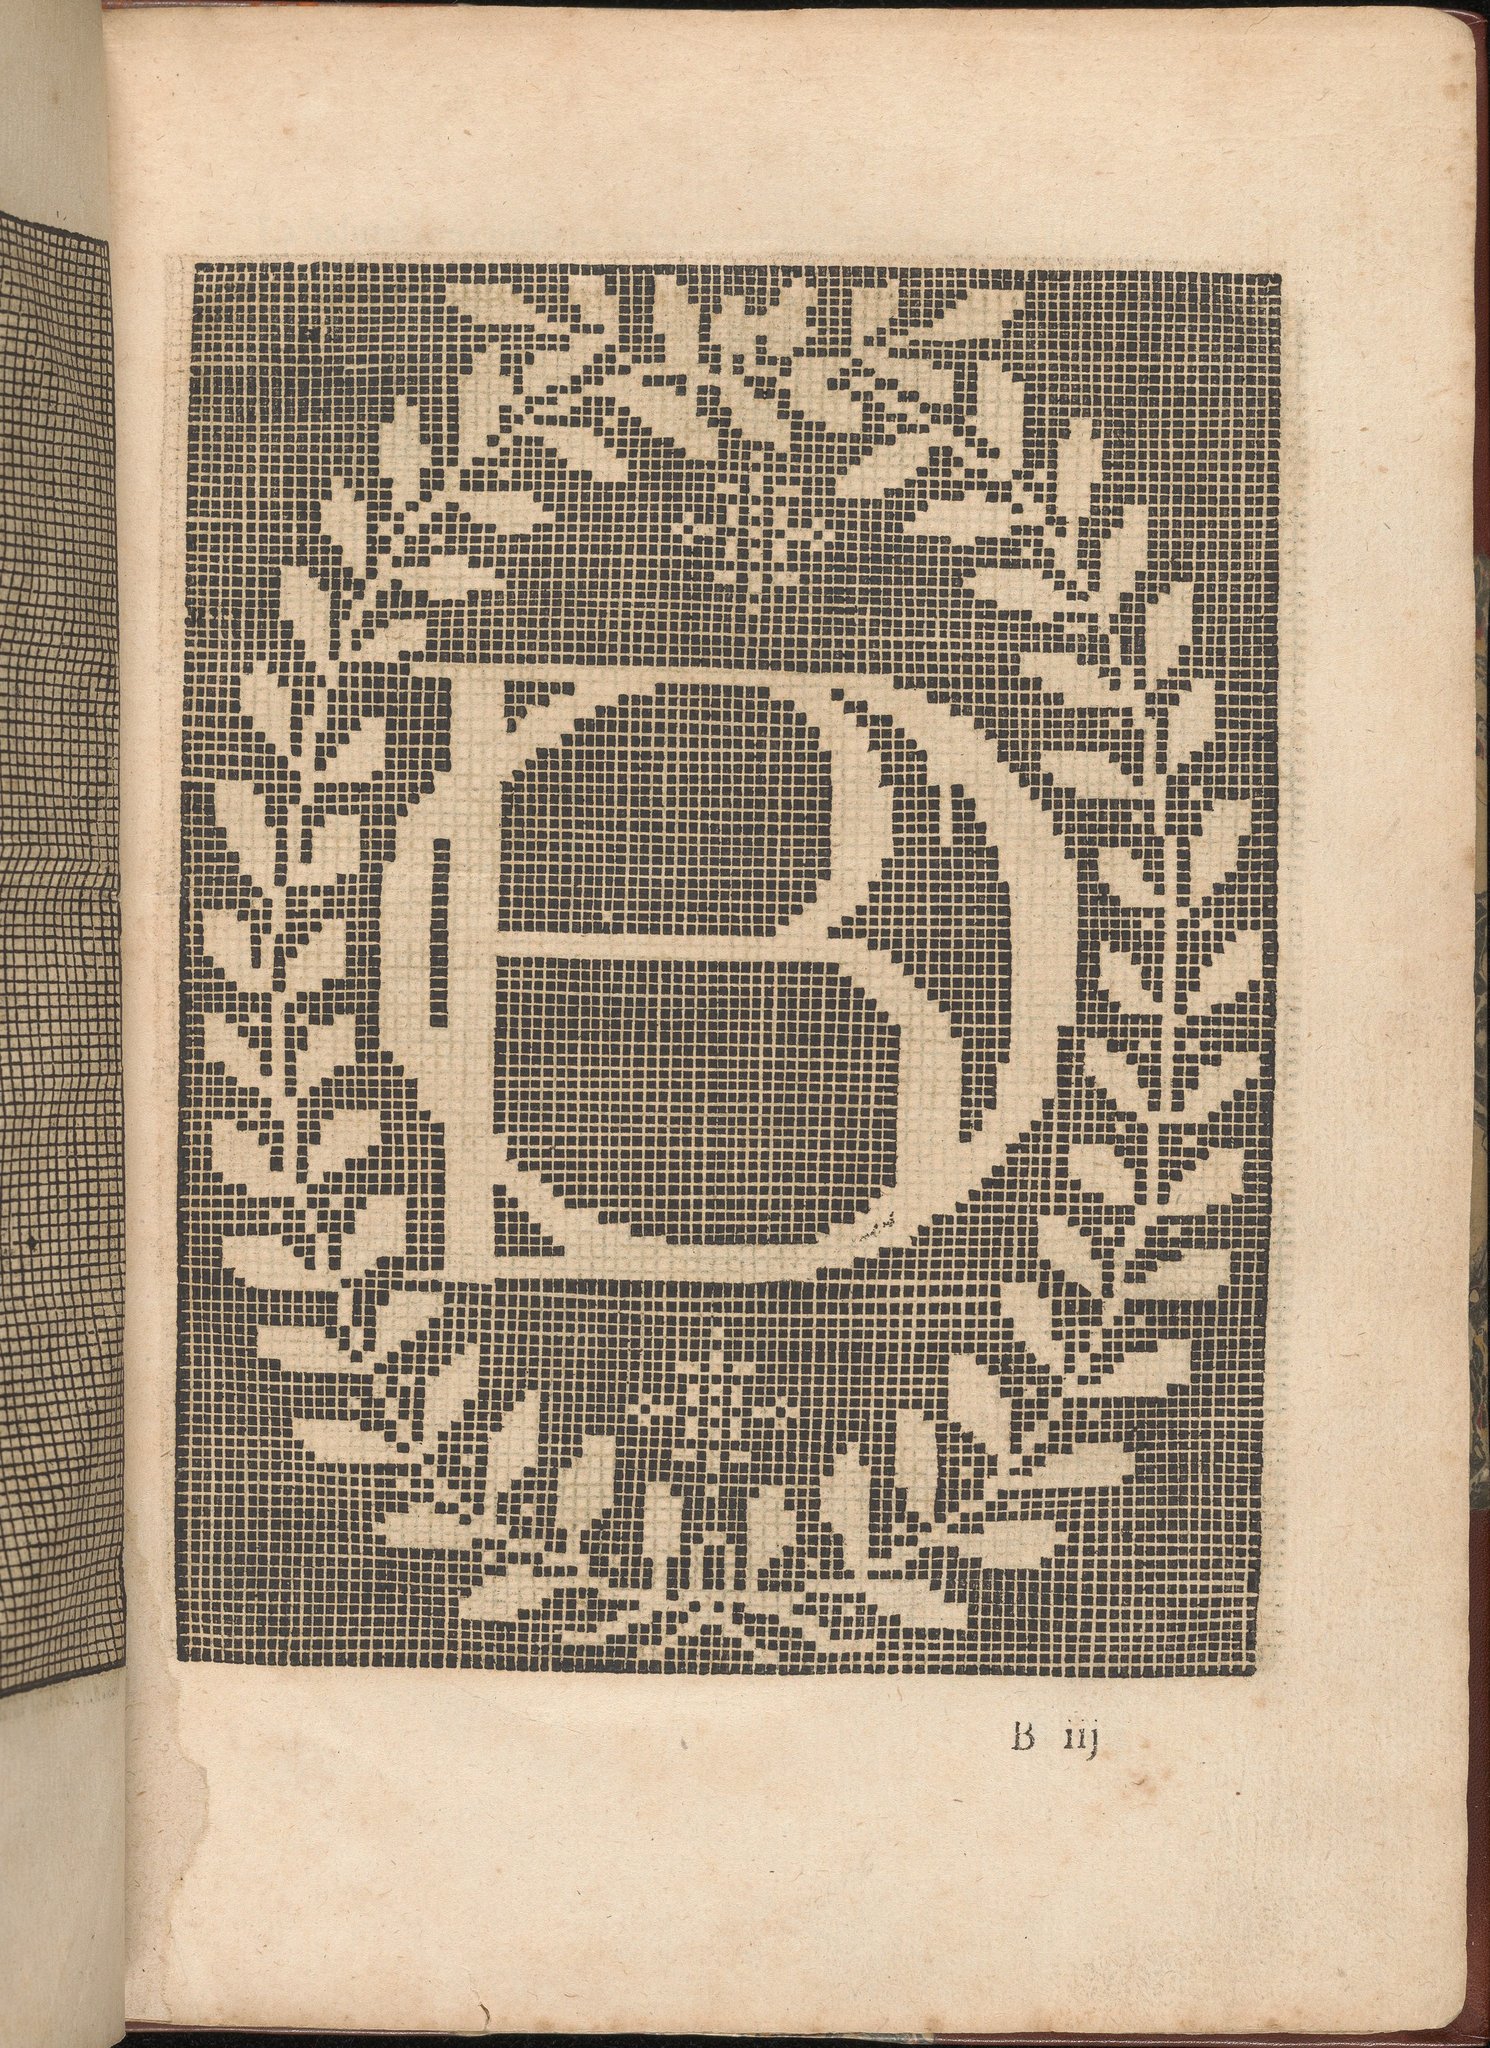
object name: book print ornament architecture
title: Les Secondes Oeuvres, et Subtiles Inventions De Lingerie du Seigneur Federic de Vinciolo Venitien, page 7 (recto)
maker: federico de vinciolo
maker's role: designer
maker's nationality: italian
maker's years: 1582-1599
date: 1603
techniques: woodcut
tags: insignia